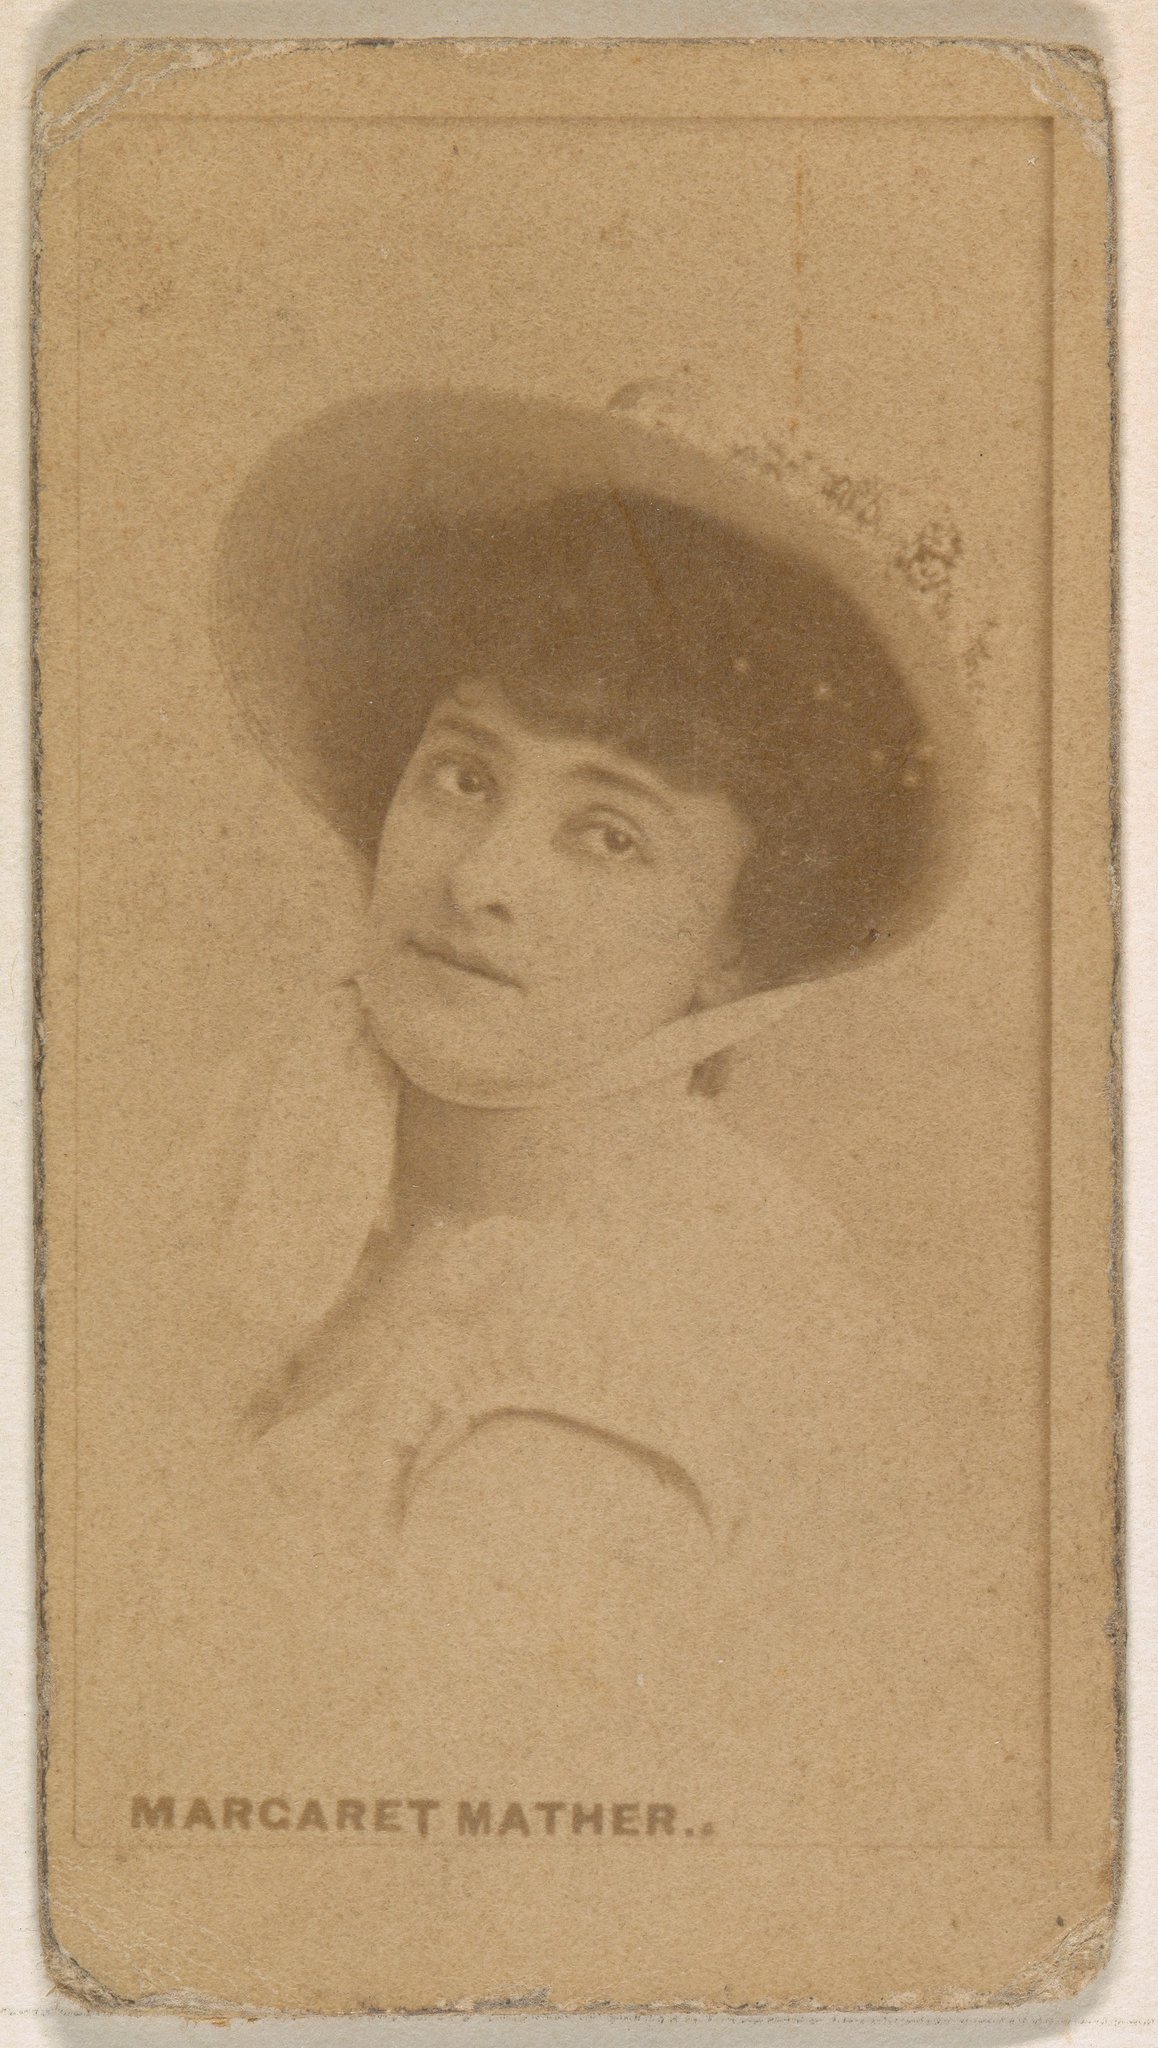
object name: photograph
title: Margaret Mather, from the Actresses series (N245) issued by Kinney Brothers to promote Sweet Caporal Cigarettes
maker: kinney brothers tobacco company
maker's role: publisher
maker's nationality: american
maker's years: 1869-2011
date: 1890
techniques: albumen silver print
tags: portraits,women,actresses